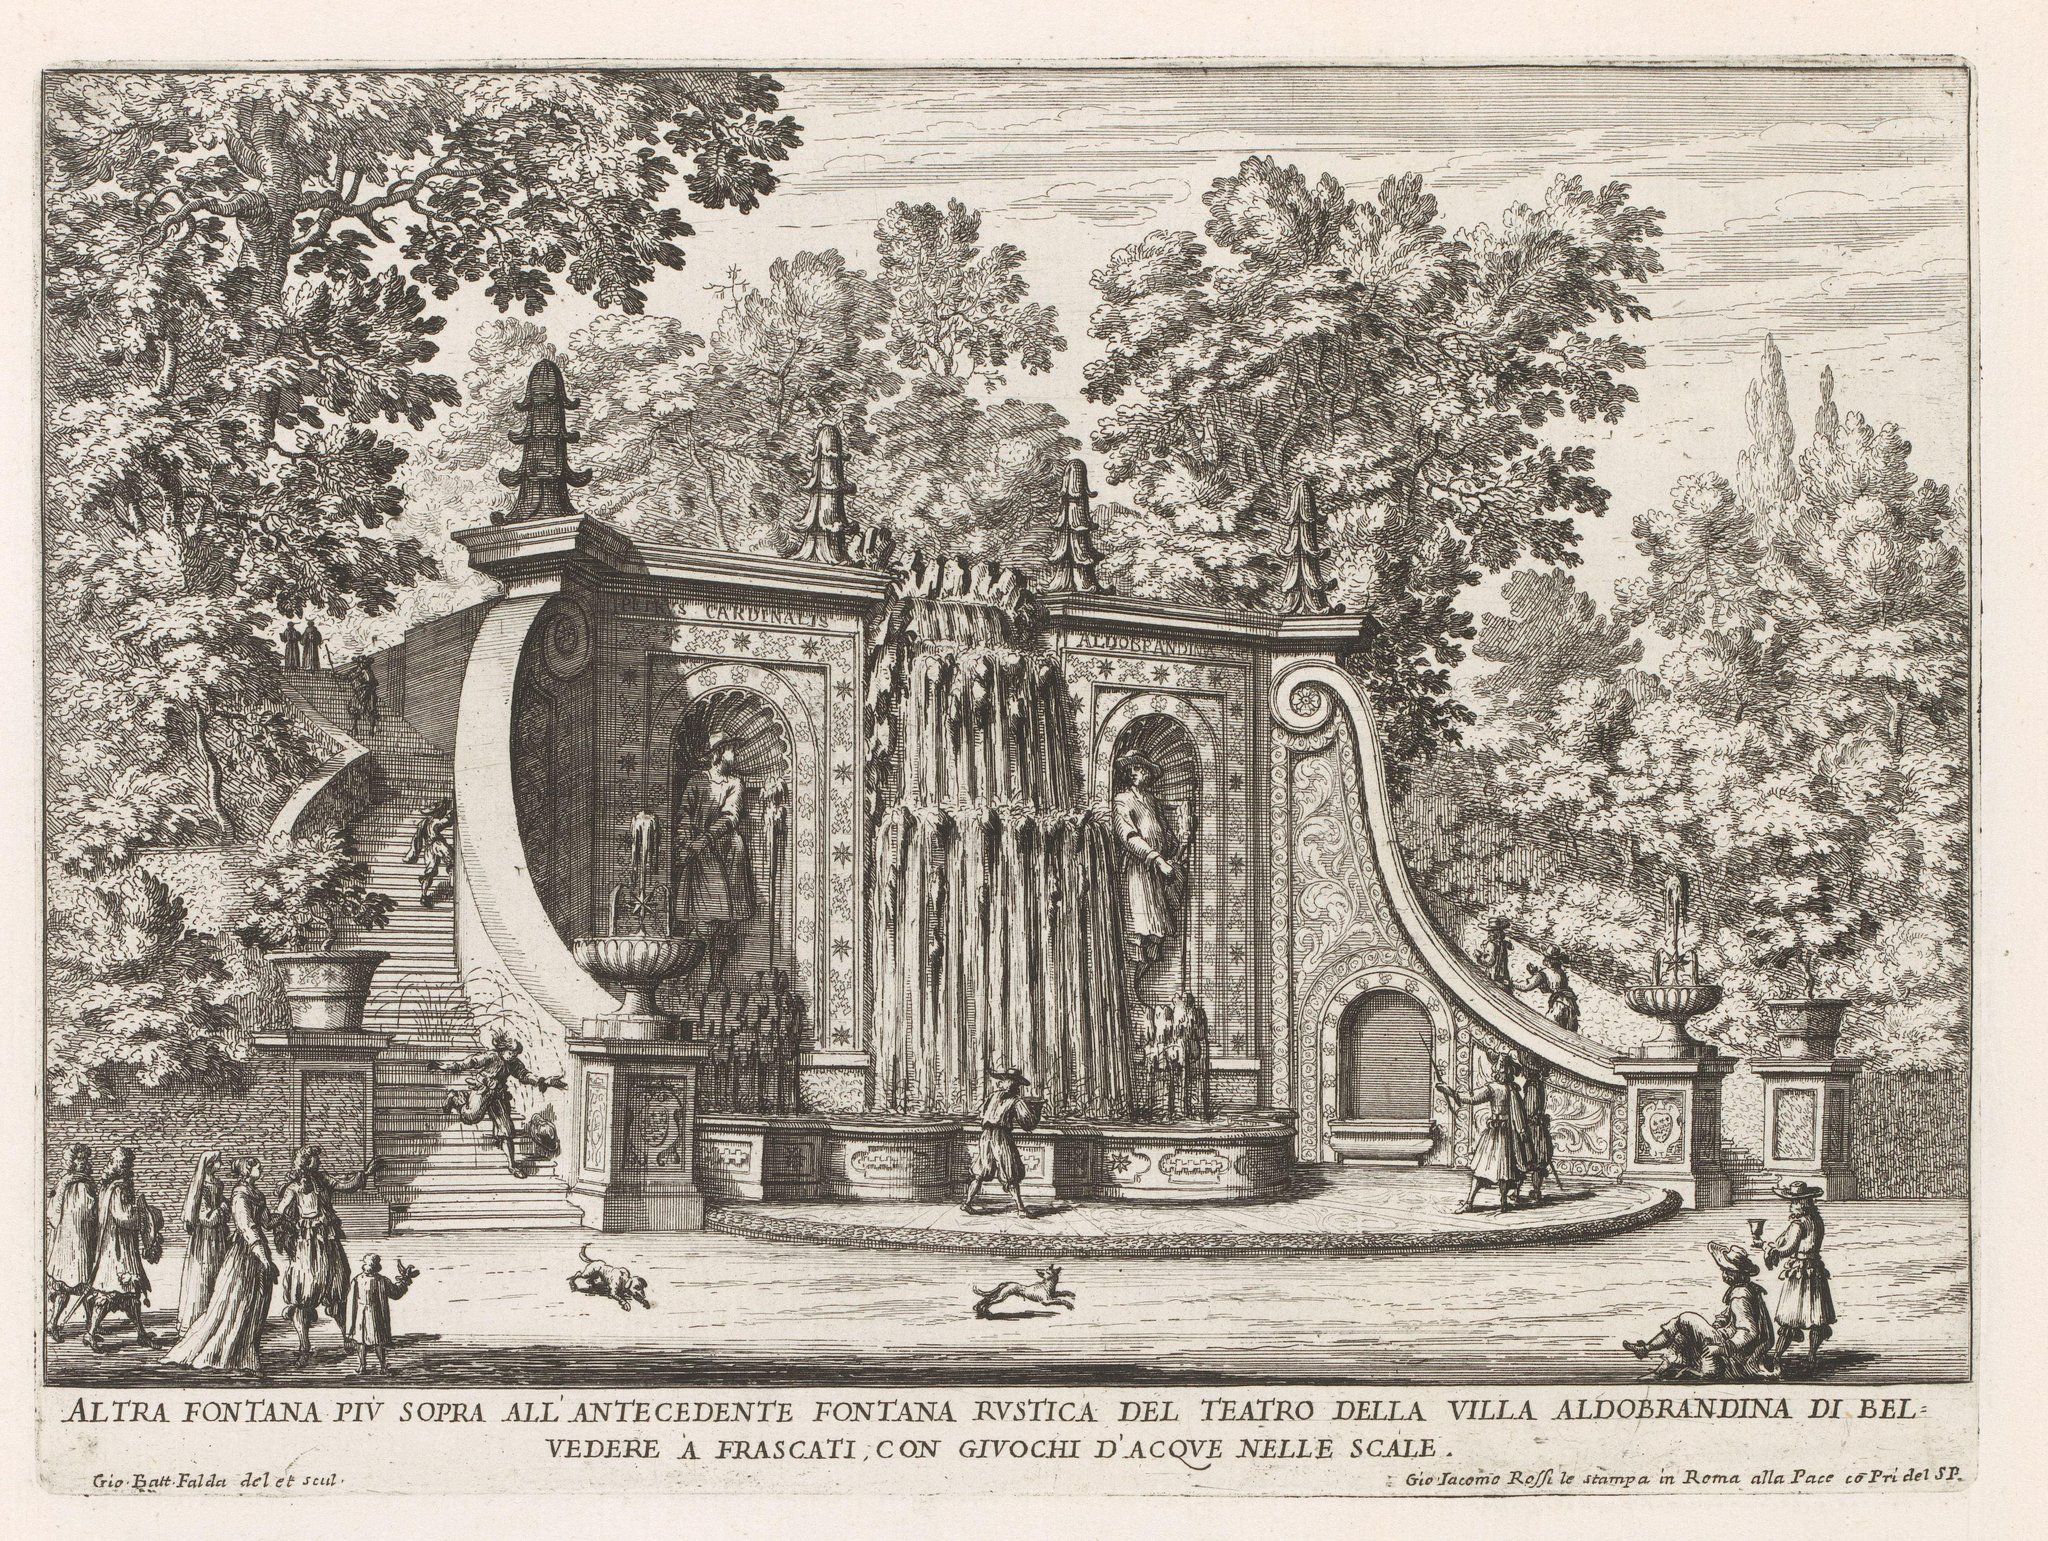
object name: album leaf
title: Fonteinen van Frascati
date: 1653-1691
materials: paper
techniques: etching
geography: italy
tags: ornamental fountain